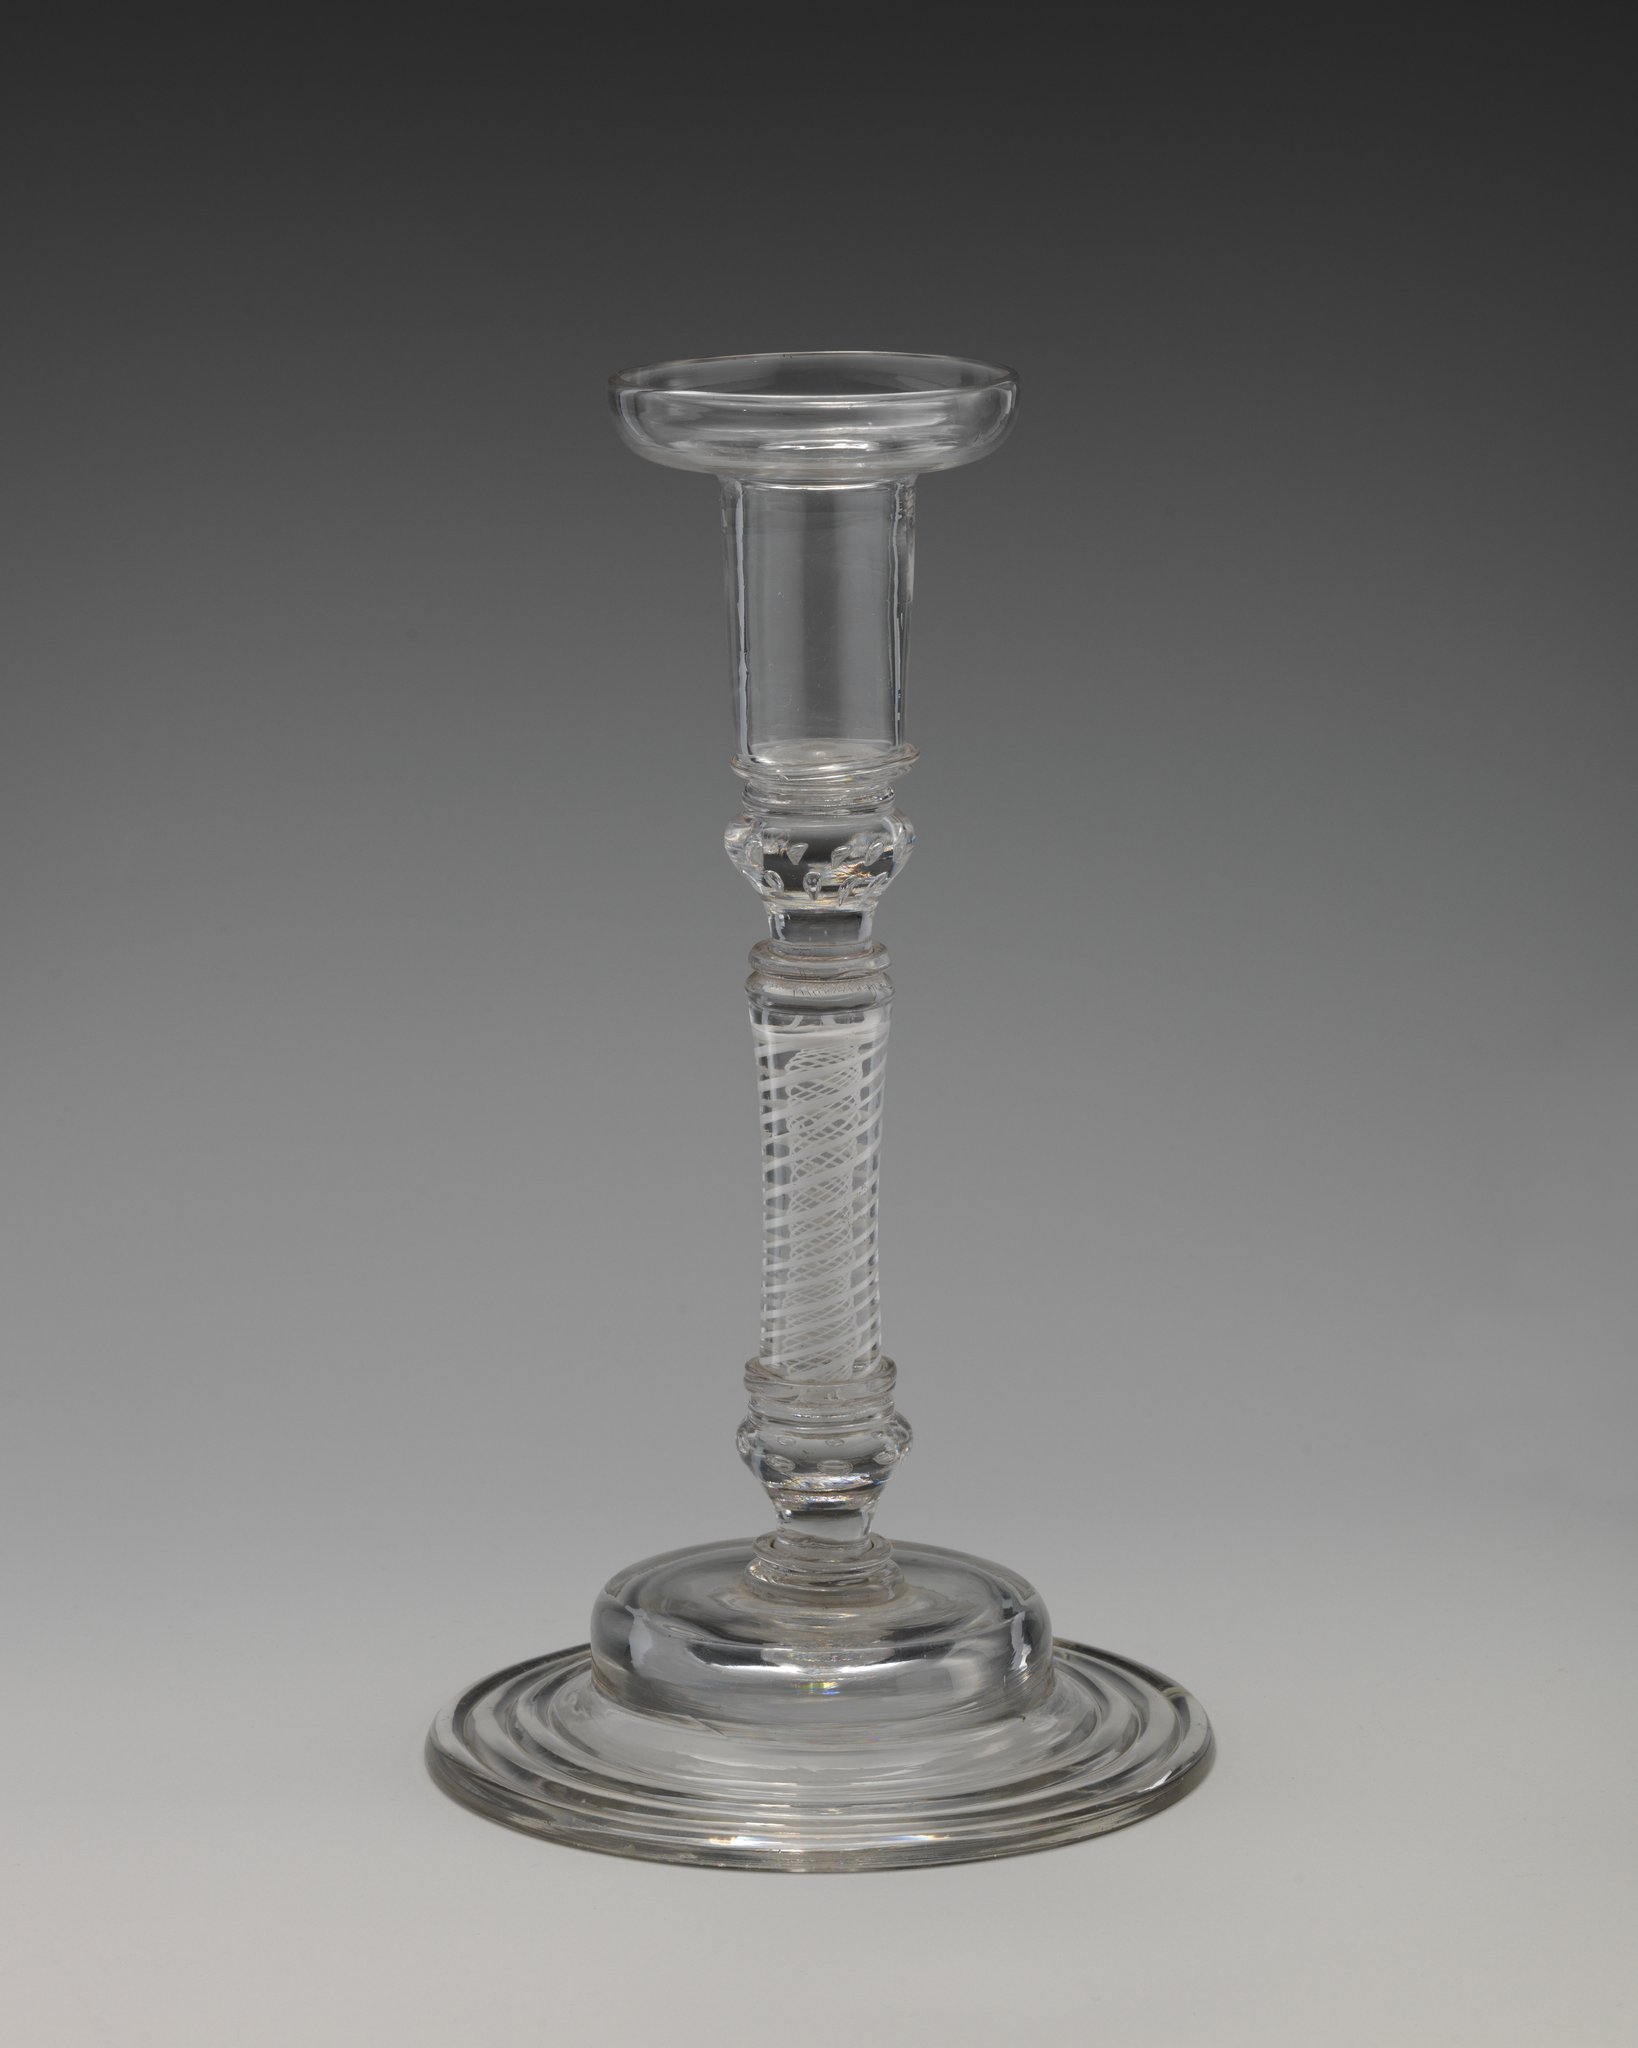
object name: candlestick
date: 1751-1800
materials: glass